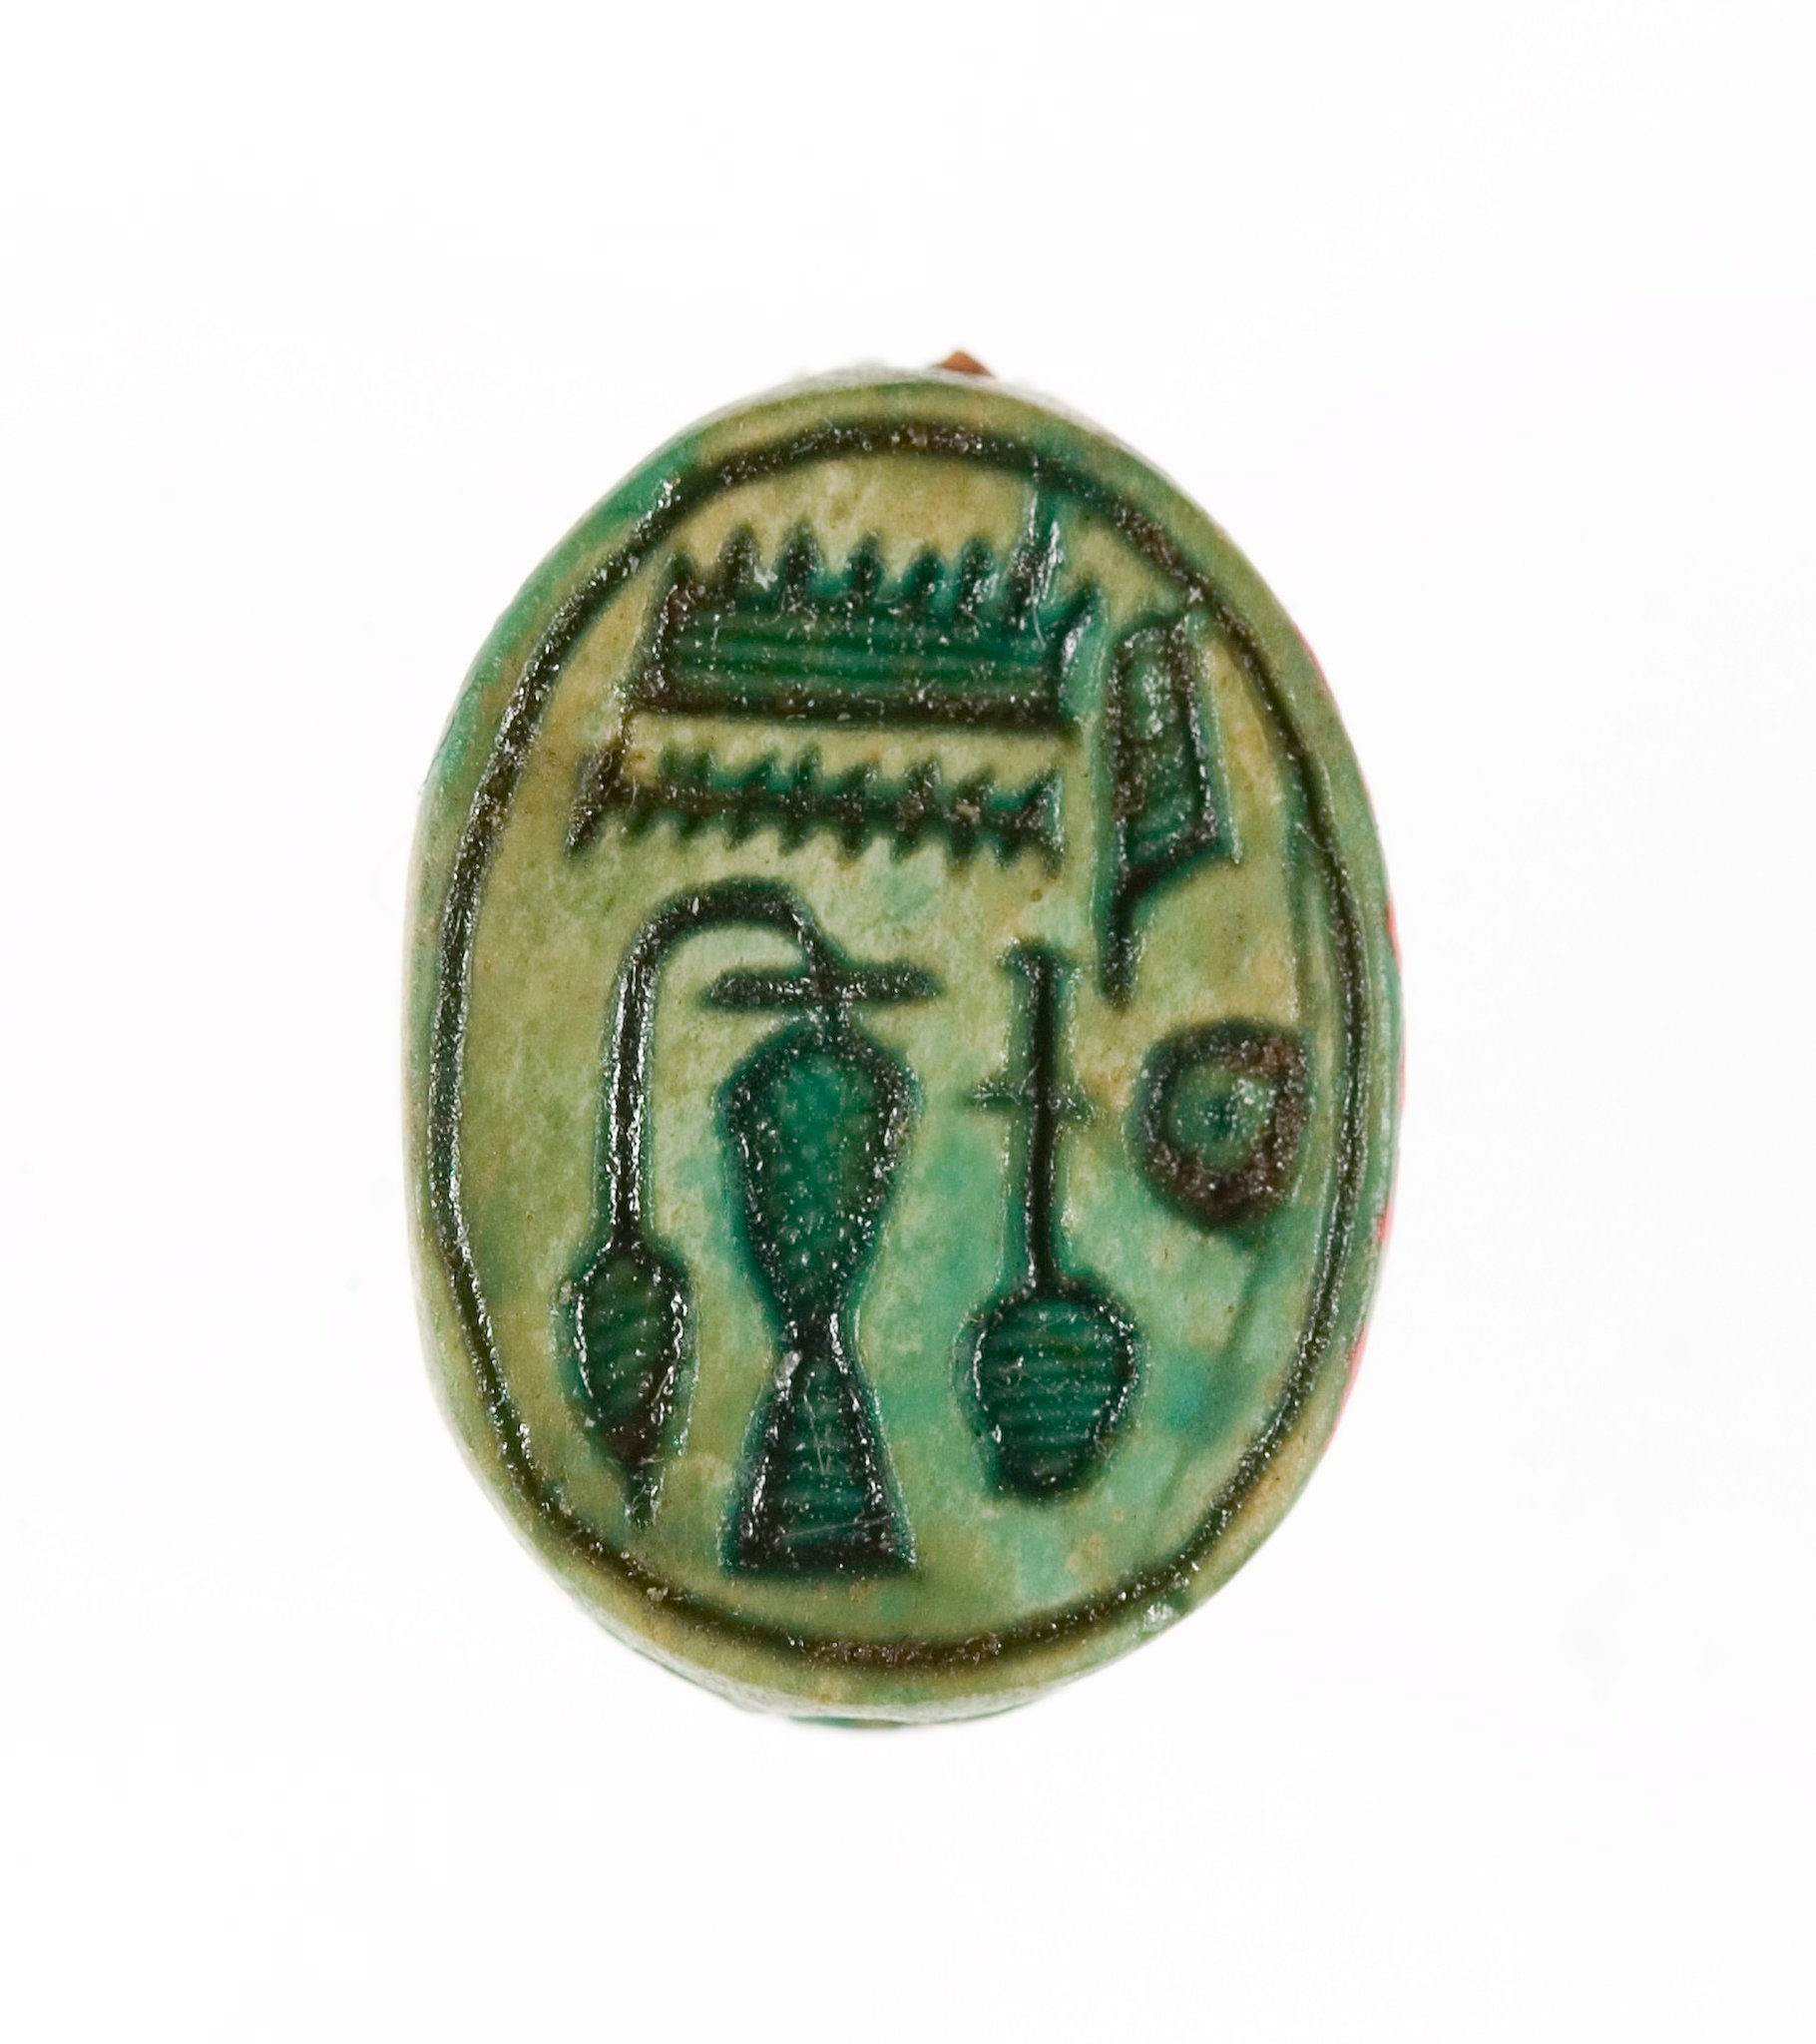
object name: scarab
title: Scarab Inscribed with the Name of the God Amun-Re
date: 1479-1458 BCE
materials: stone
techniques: glazing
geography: egypt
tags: hieroglyphs,scarabs